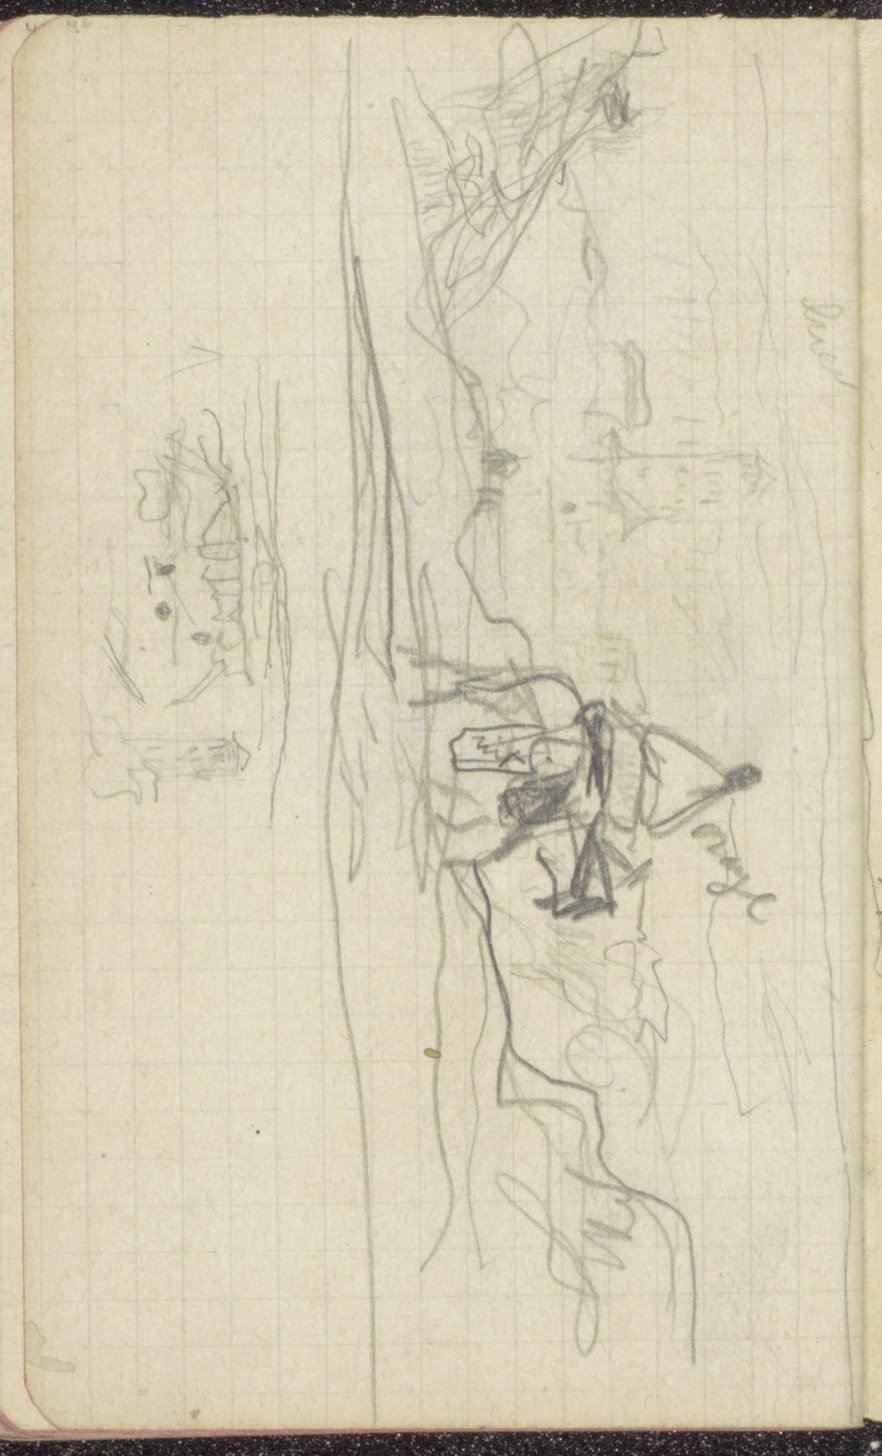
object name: sketchbook leaf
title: Heuvellandschap met een figuur op een ezel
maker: marius bauer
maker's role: draughtsman, print maker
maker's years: 1867-1932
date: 1902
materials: pencil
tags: city-view, and landscape with man-made constructions, low hill country, sitting figure, ass, donkey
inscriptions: kleurnotitie, handgeschreven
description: Op de achtergrond zijn gebouwen en een toren van een stad of dorp te zien. Pagina 46 uit een schetsboek met 23 bladen.